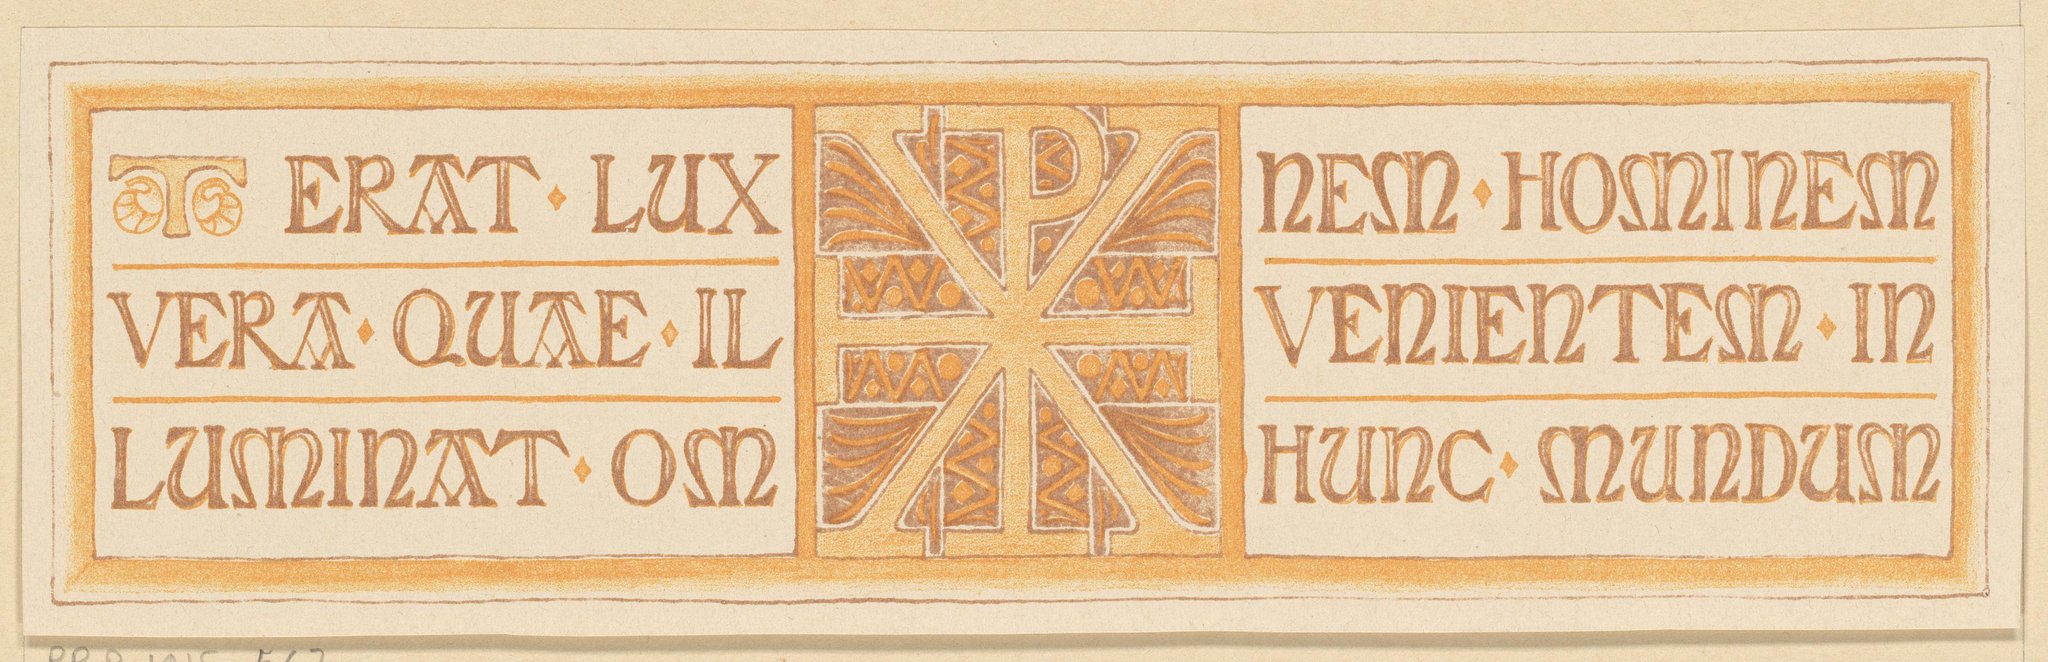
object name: book illustration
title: Erat lux vera, quae illuminat omnem hominem venientem in hunc mundum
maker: antoon derkinderen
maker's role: draughtsman, painter, print maker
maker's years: 1859-1925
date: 1895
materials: paper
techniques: lithograph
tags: labarum, i.e. imperial standard bearing the christogram ihs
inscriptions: collector's mark: Lugt 2233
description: Prent gebruikt voor: Diepenbrock, Alphons. Missa. Amsterdam: Algemeene Muziekhandel, 1895.